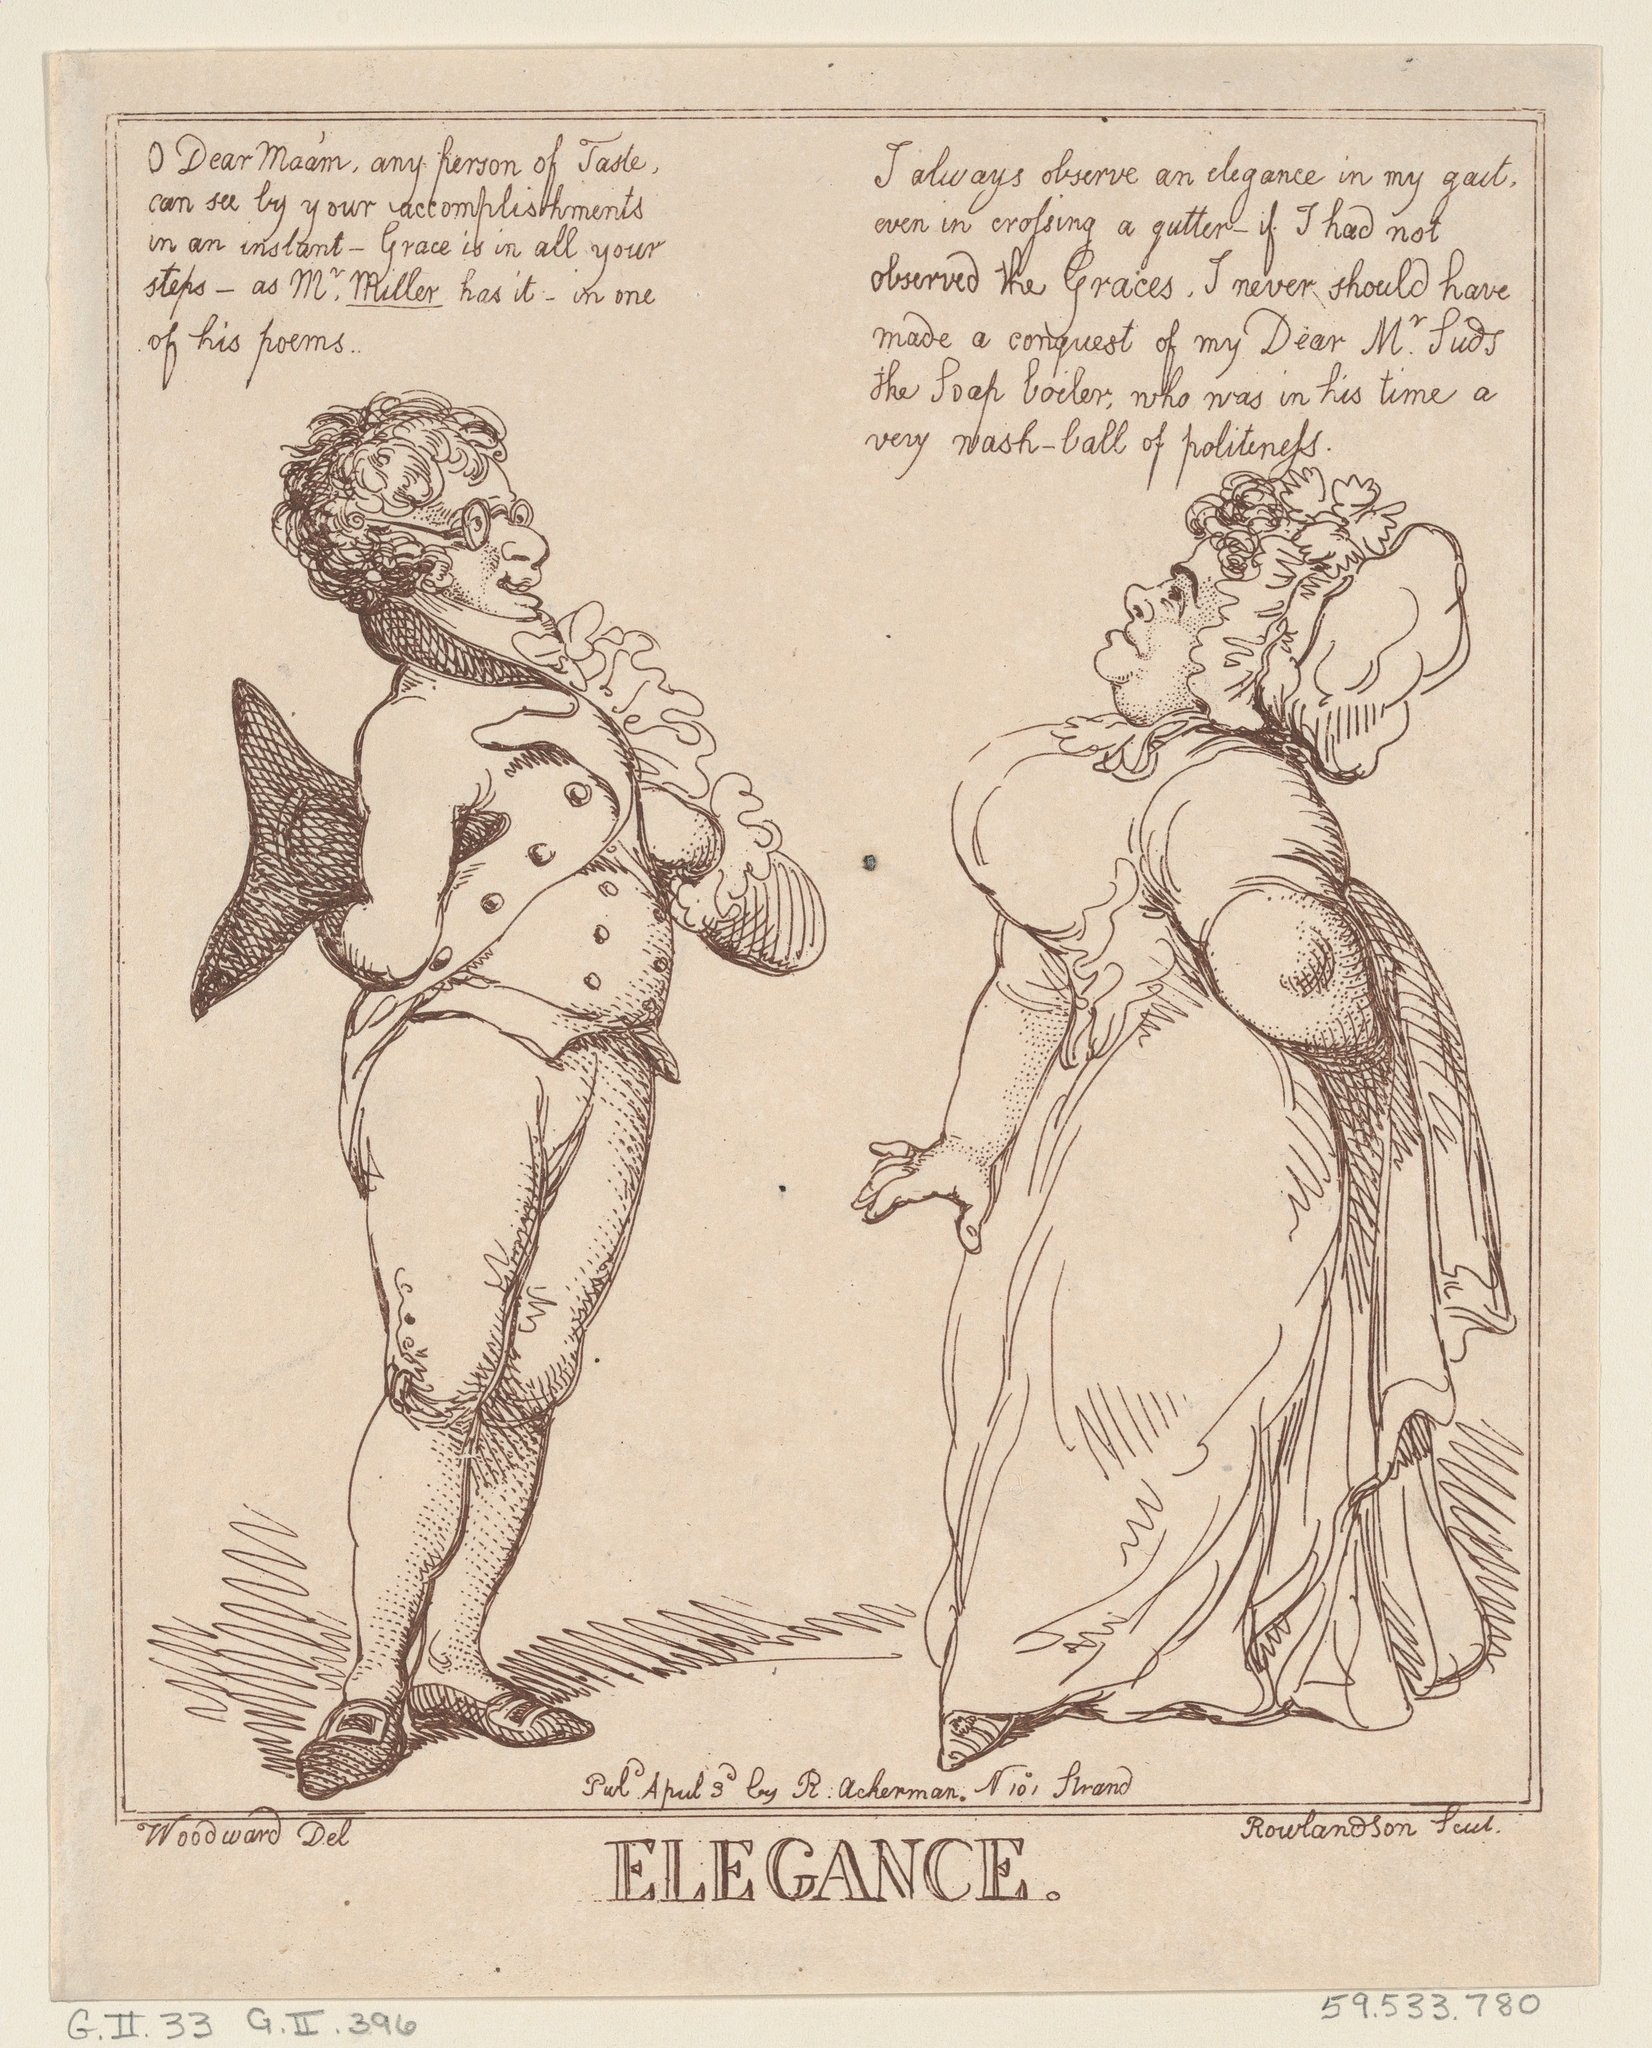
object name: print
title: Elegance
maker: thomas rowlandson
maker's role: artist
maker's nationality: british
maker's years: 1757-1827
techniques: etching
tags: satire,men,women